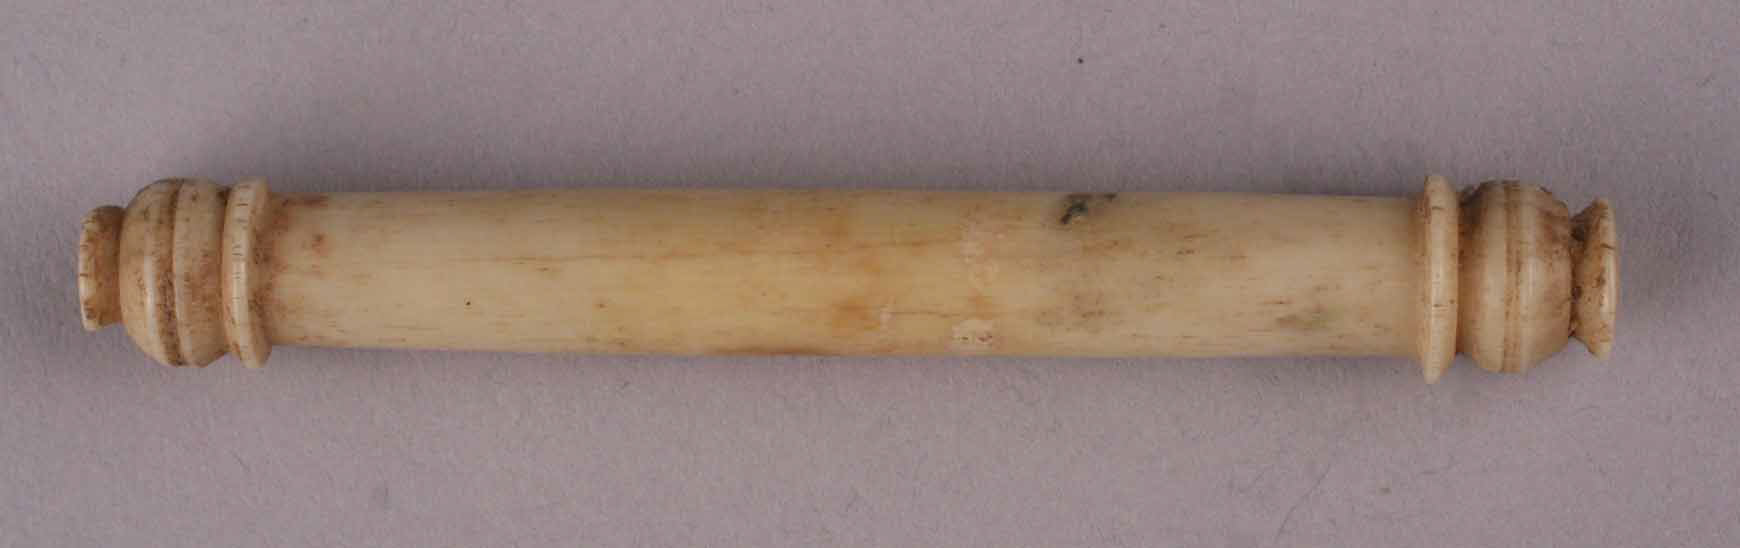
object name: bobbin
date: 801-1000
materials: bone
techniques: carving, incising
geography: iran